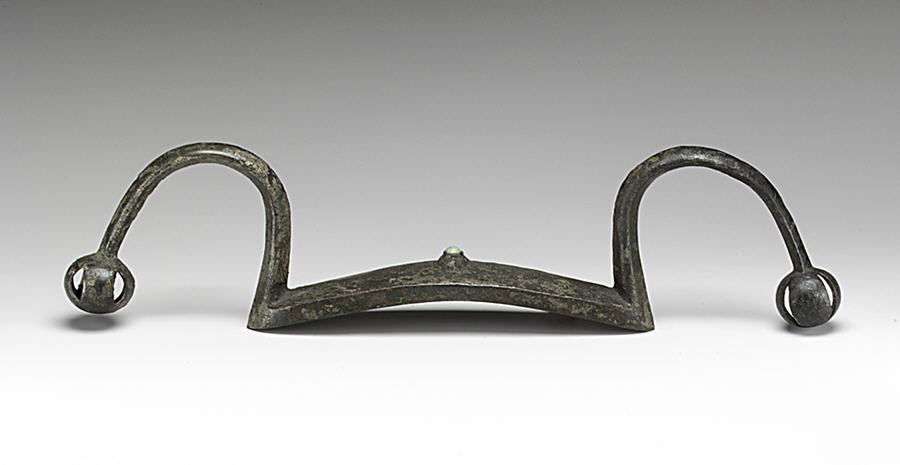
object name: fitting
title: Bow-Shaped Fitting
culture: northwest chinese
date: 1300-901 BCE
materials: bronze